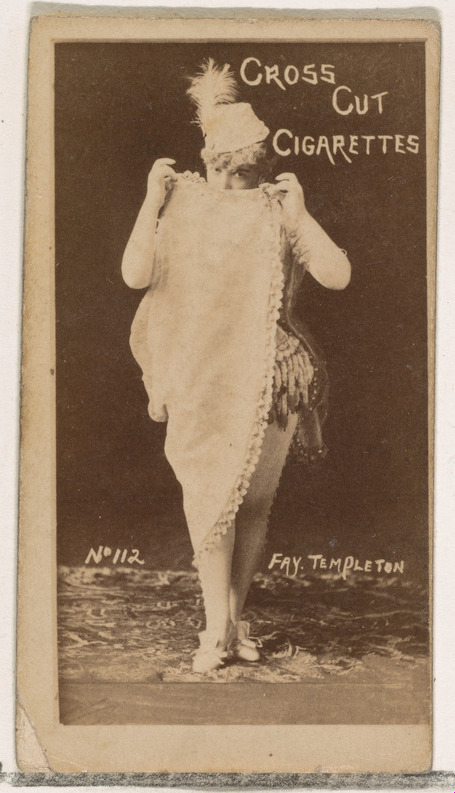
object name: print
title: Card Number 112, Fay Templeton, from the Actors and Actresses series (N145-1) issued by Duke Sons & Co. to promote Cross Cut Cigarettes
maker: w. duke, sons & co.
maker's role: publisher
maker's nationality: american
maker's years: 1870-1920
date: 1880-1889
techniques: albumen silver print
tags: portraits,women,actresses